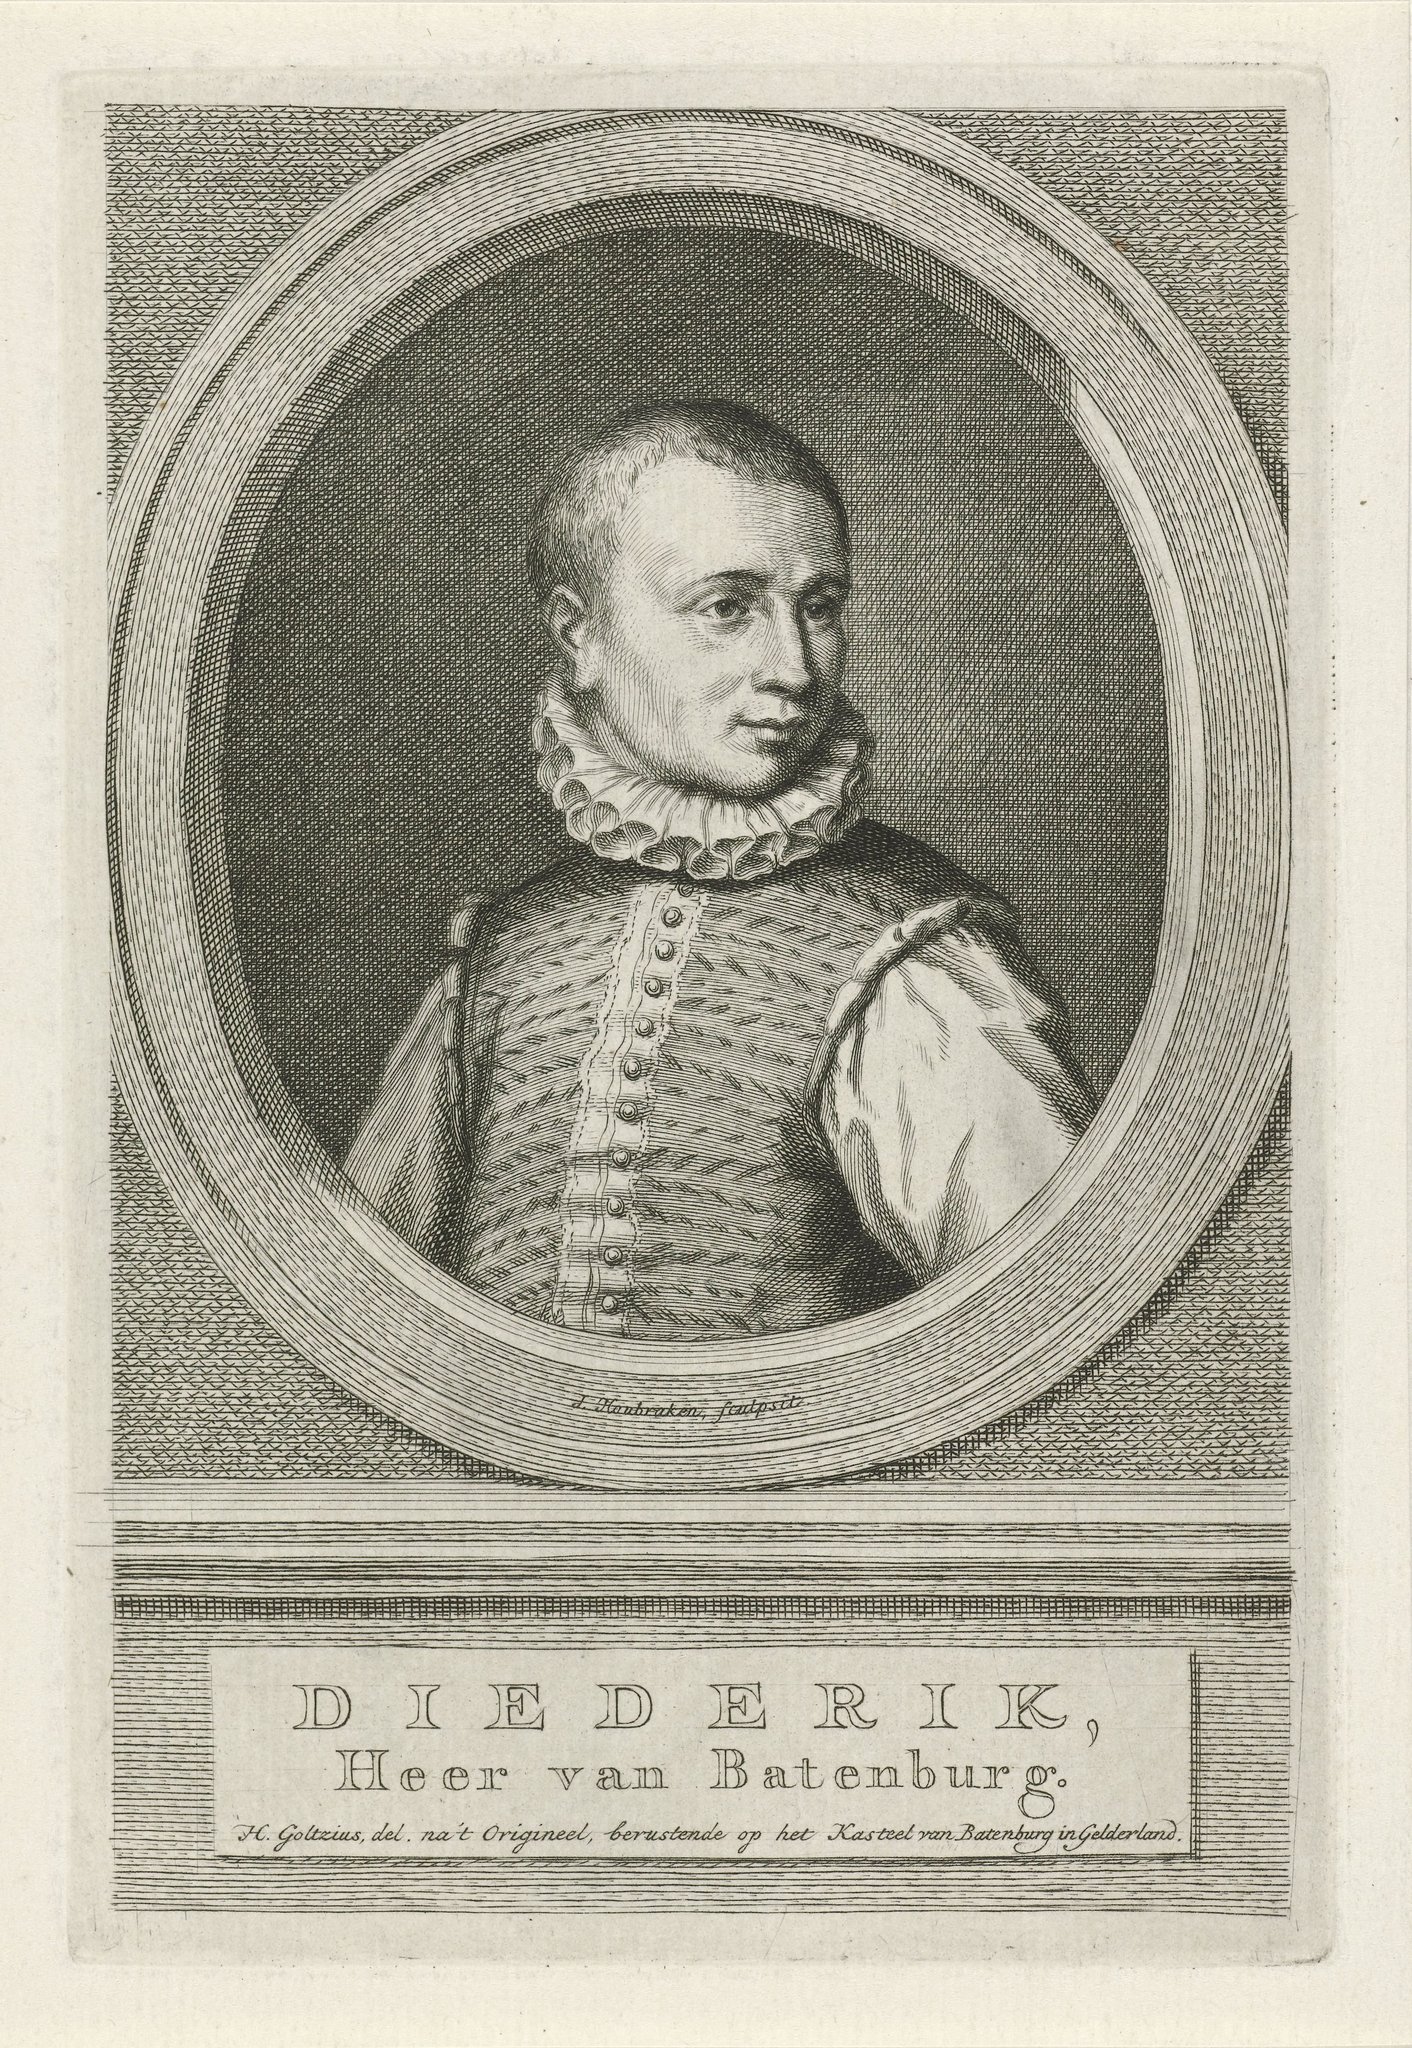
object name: print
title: Portret van Dirk van Bronckhorst en Batenburg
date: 1749-1759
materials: paper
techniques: engraving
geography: amsterdam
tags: raadsheer, diderik van batenburg, verbond der edelen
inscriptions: collector's mark: Lugt 2228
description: Prent oorspronkelijk bedoeld voor: Jan Wagenaar, Vaderlandsche historie, vervattende de geschiedenissen der nu Vereenigde Nederlanden, inzonderheid die van Holland (...), 21 delen. Amsterdam, Isaak Tirion, 1749-59.